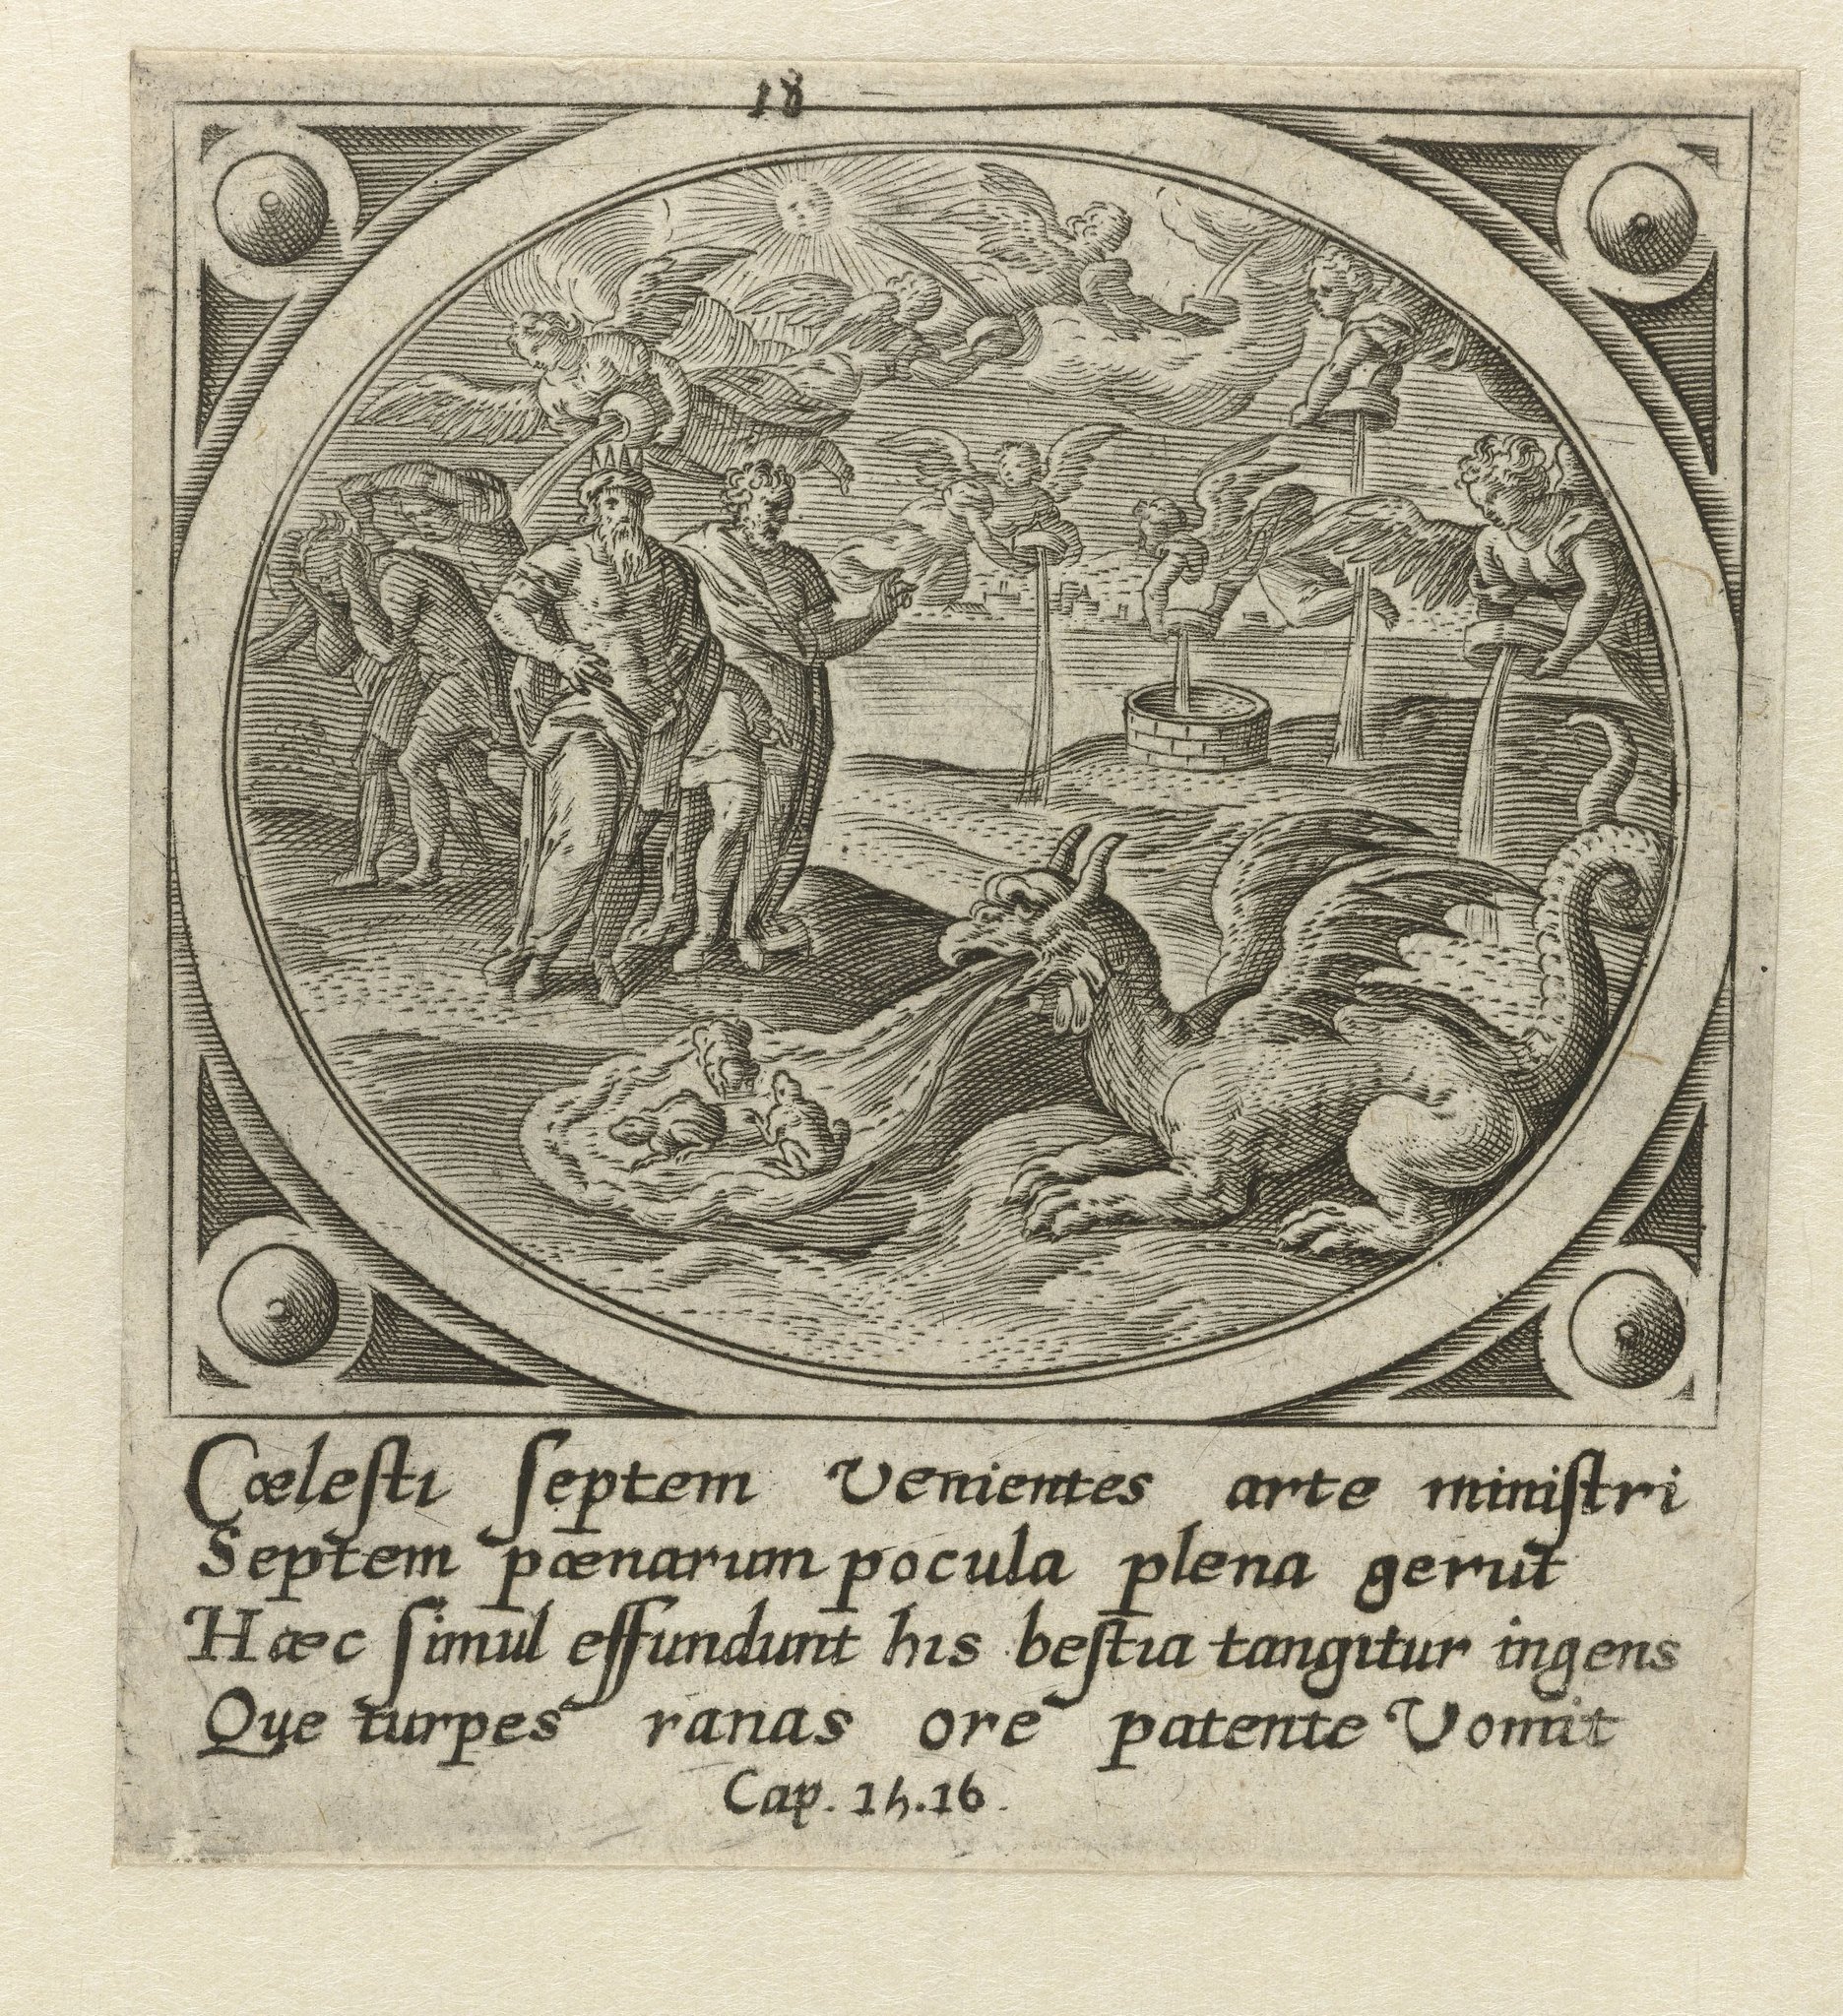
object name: print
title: Zeven plagen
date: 1585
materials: paper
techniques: engraving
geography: antwerp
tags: the seven angels with the seven vials, bringing disasters and destruction upon the earth and mankind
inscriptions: collector's mark: Lugt 2760, collector's mark: Lugt 2228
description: Engelen gieten schalen leeg die plagen veroorzaken. Op de voorgrond de zesde plaag: een draak die kikkers braakt. In de marge een vierregelig onderschrift in het Latijn. Achttiende prent uit een serie van vierentwintig met de openbaring van Johannes op Patmos.